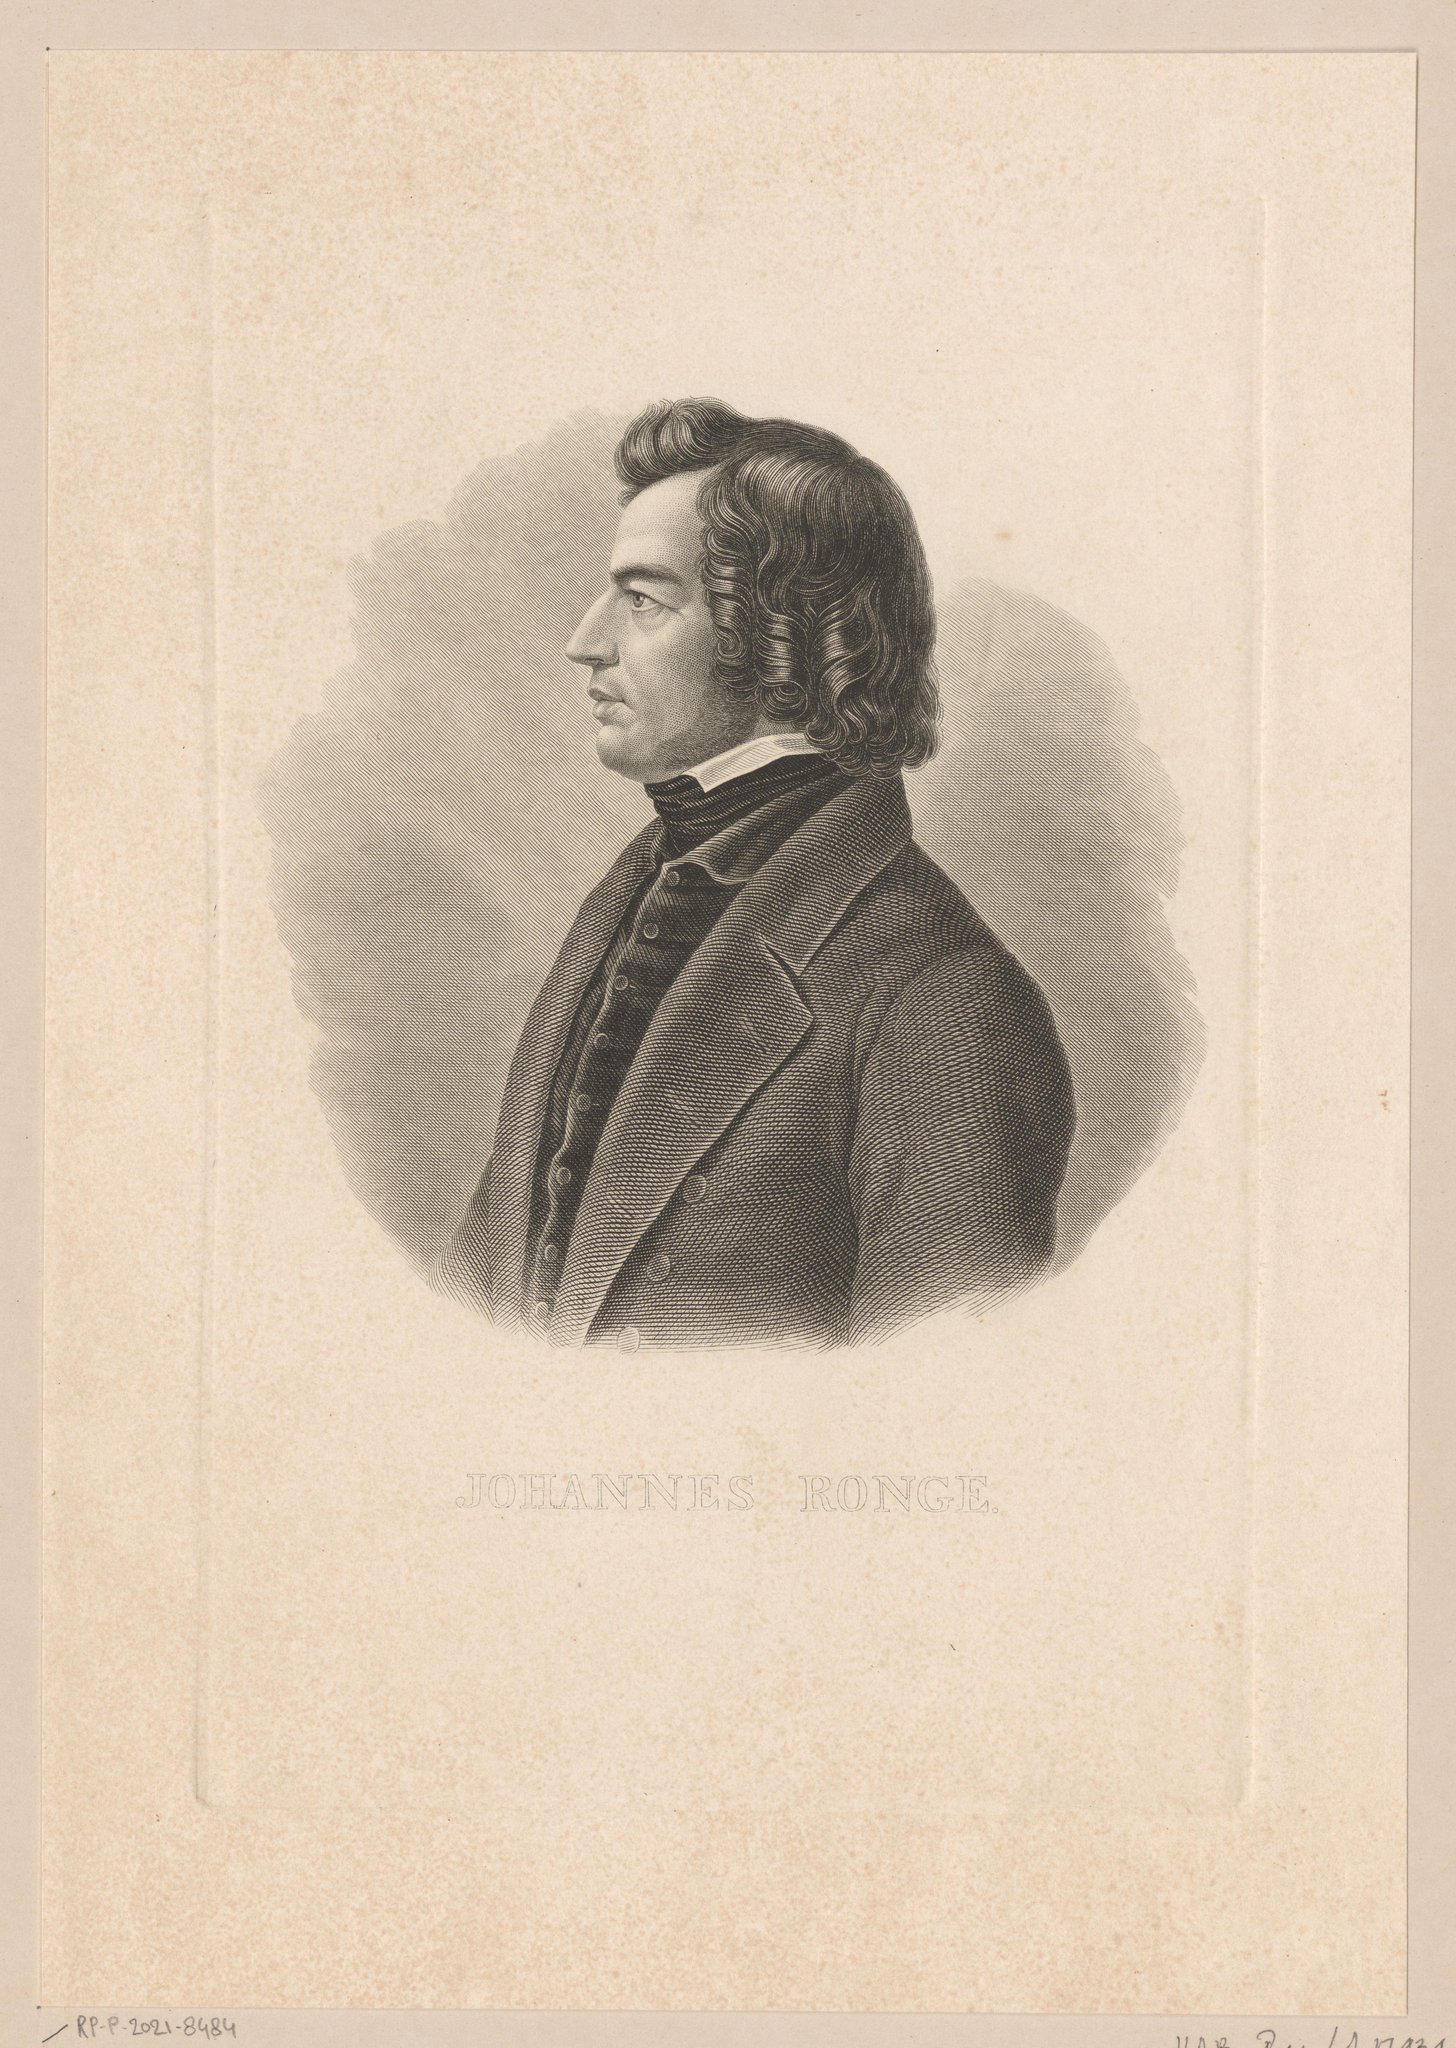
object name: print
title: Portret van Johannes Ronge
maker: Anonymous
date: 1833-1899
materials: paper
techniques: engraving, etching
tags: vienna, historical persons